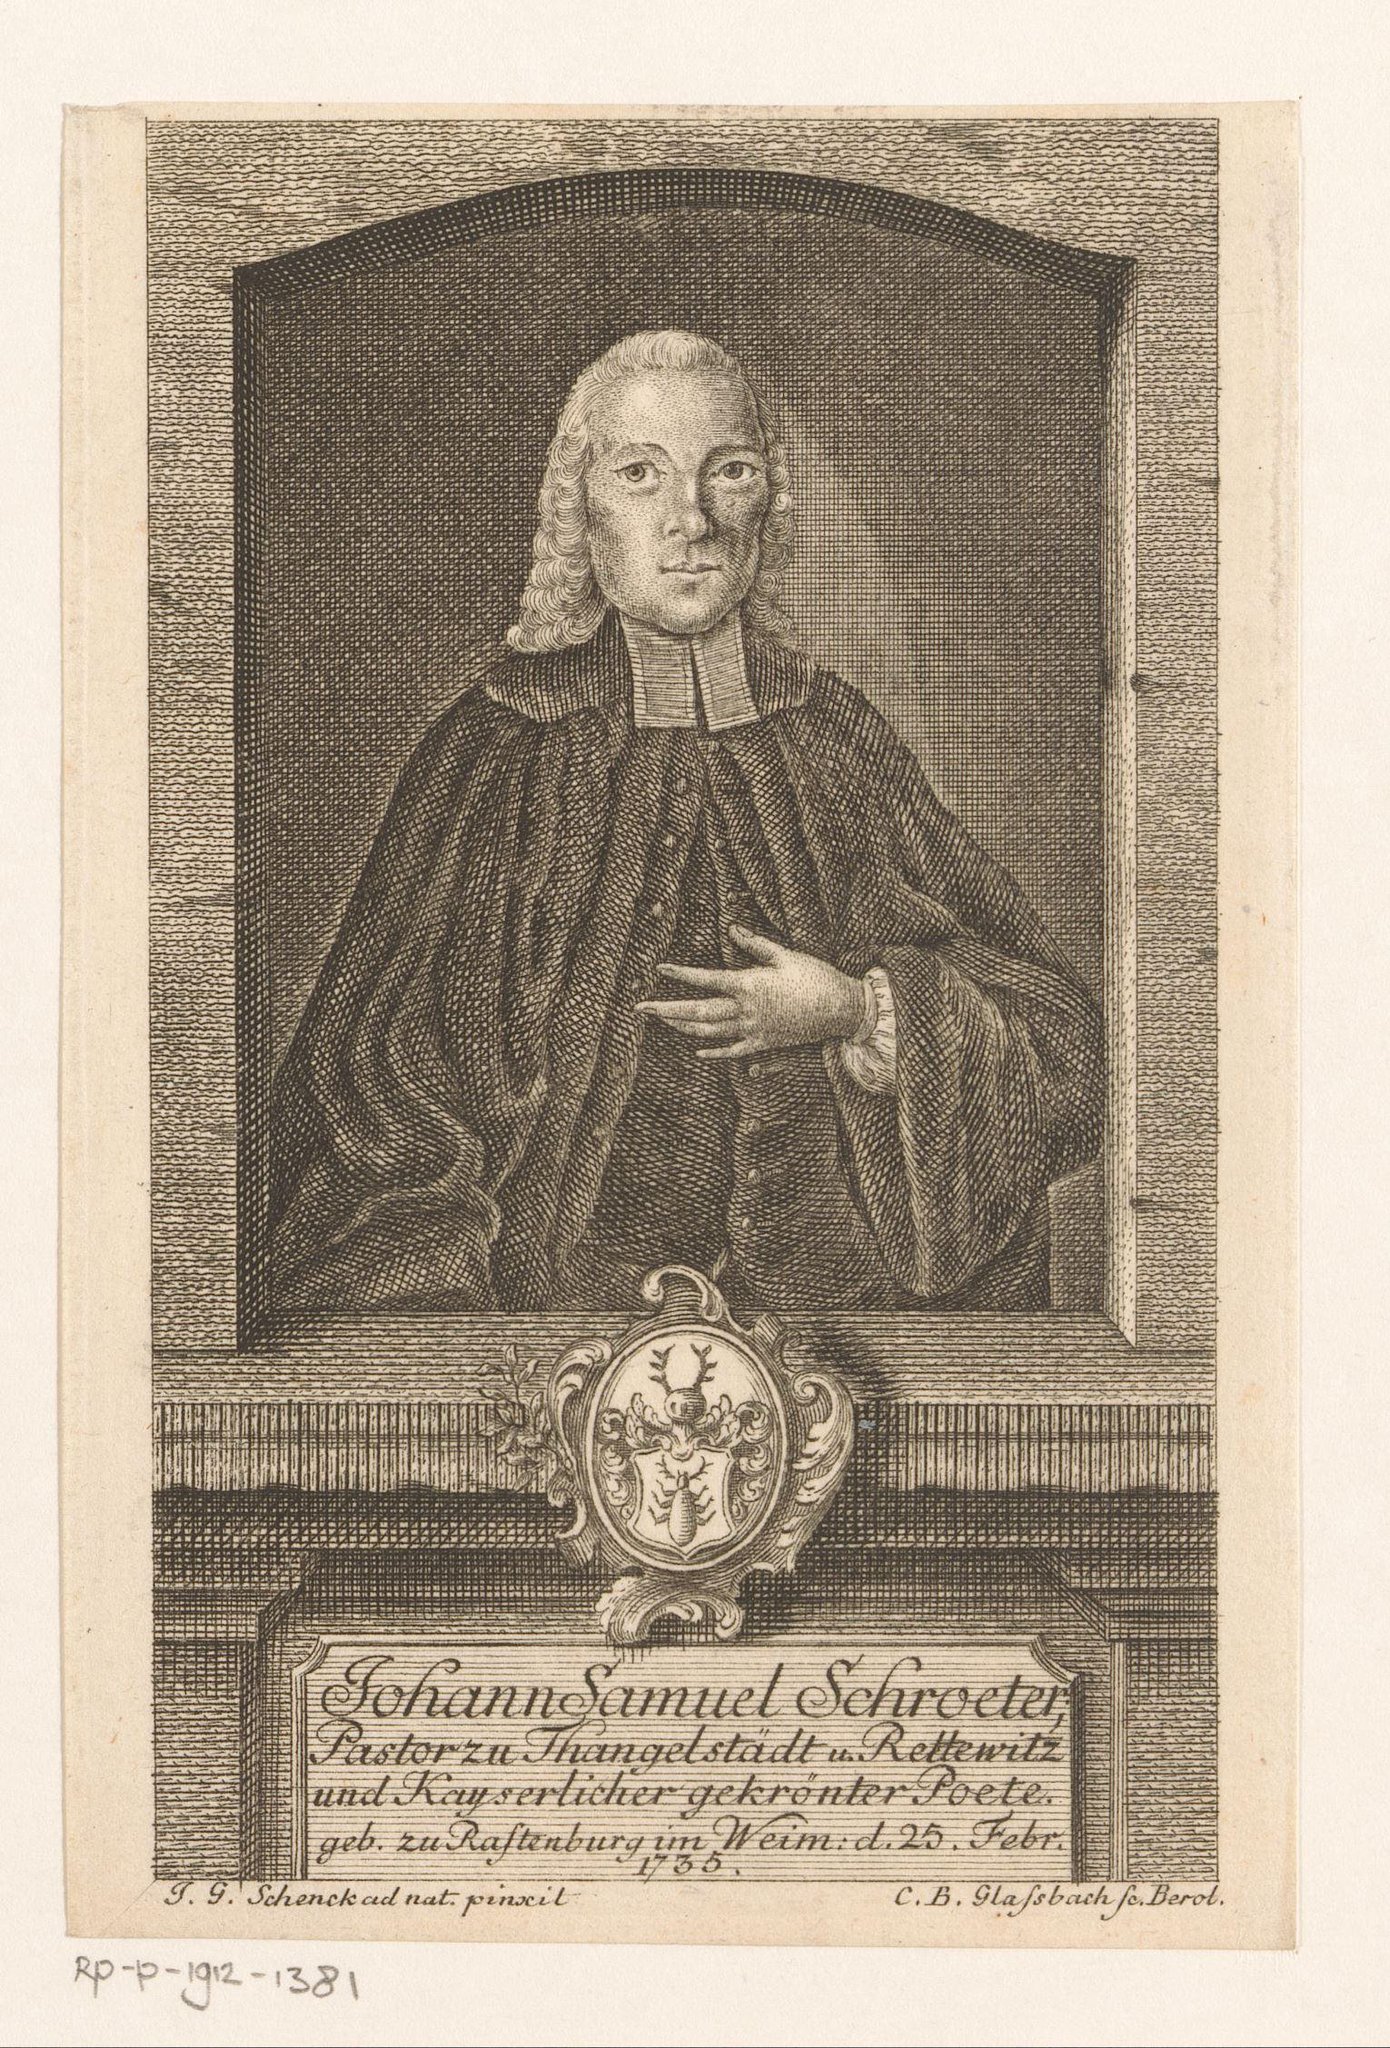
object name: print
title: Portret van Johann Samuel Schröter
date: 1745-1779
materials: paper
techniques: engraving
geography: berlin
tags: historical persons, armorial bearing, heraldry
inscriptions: collector's mark: Lugt 2228